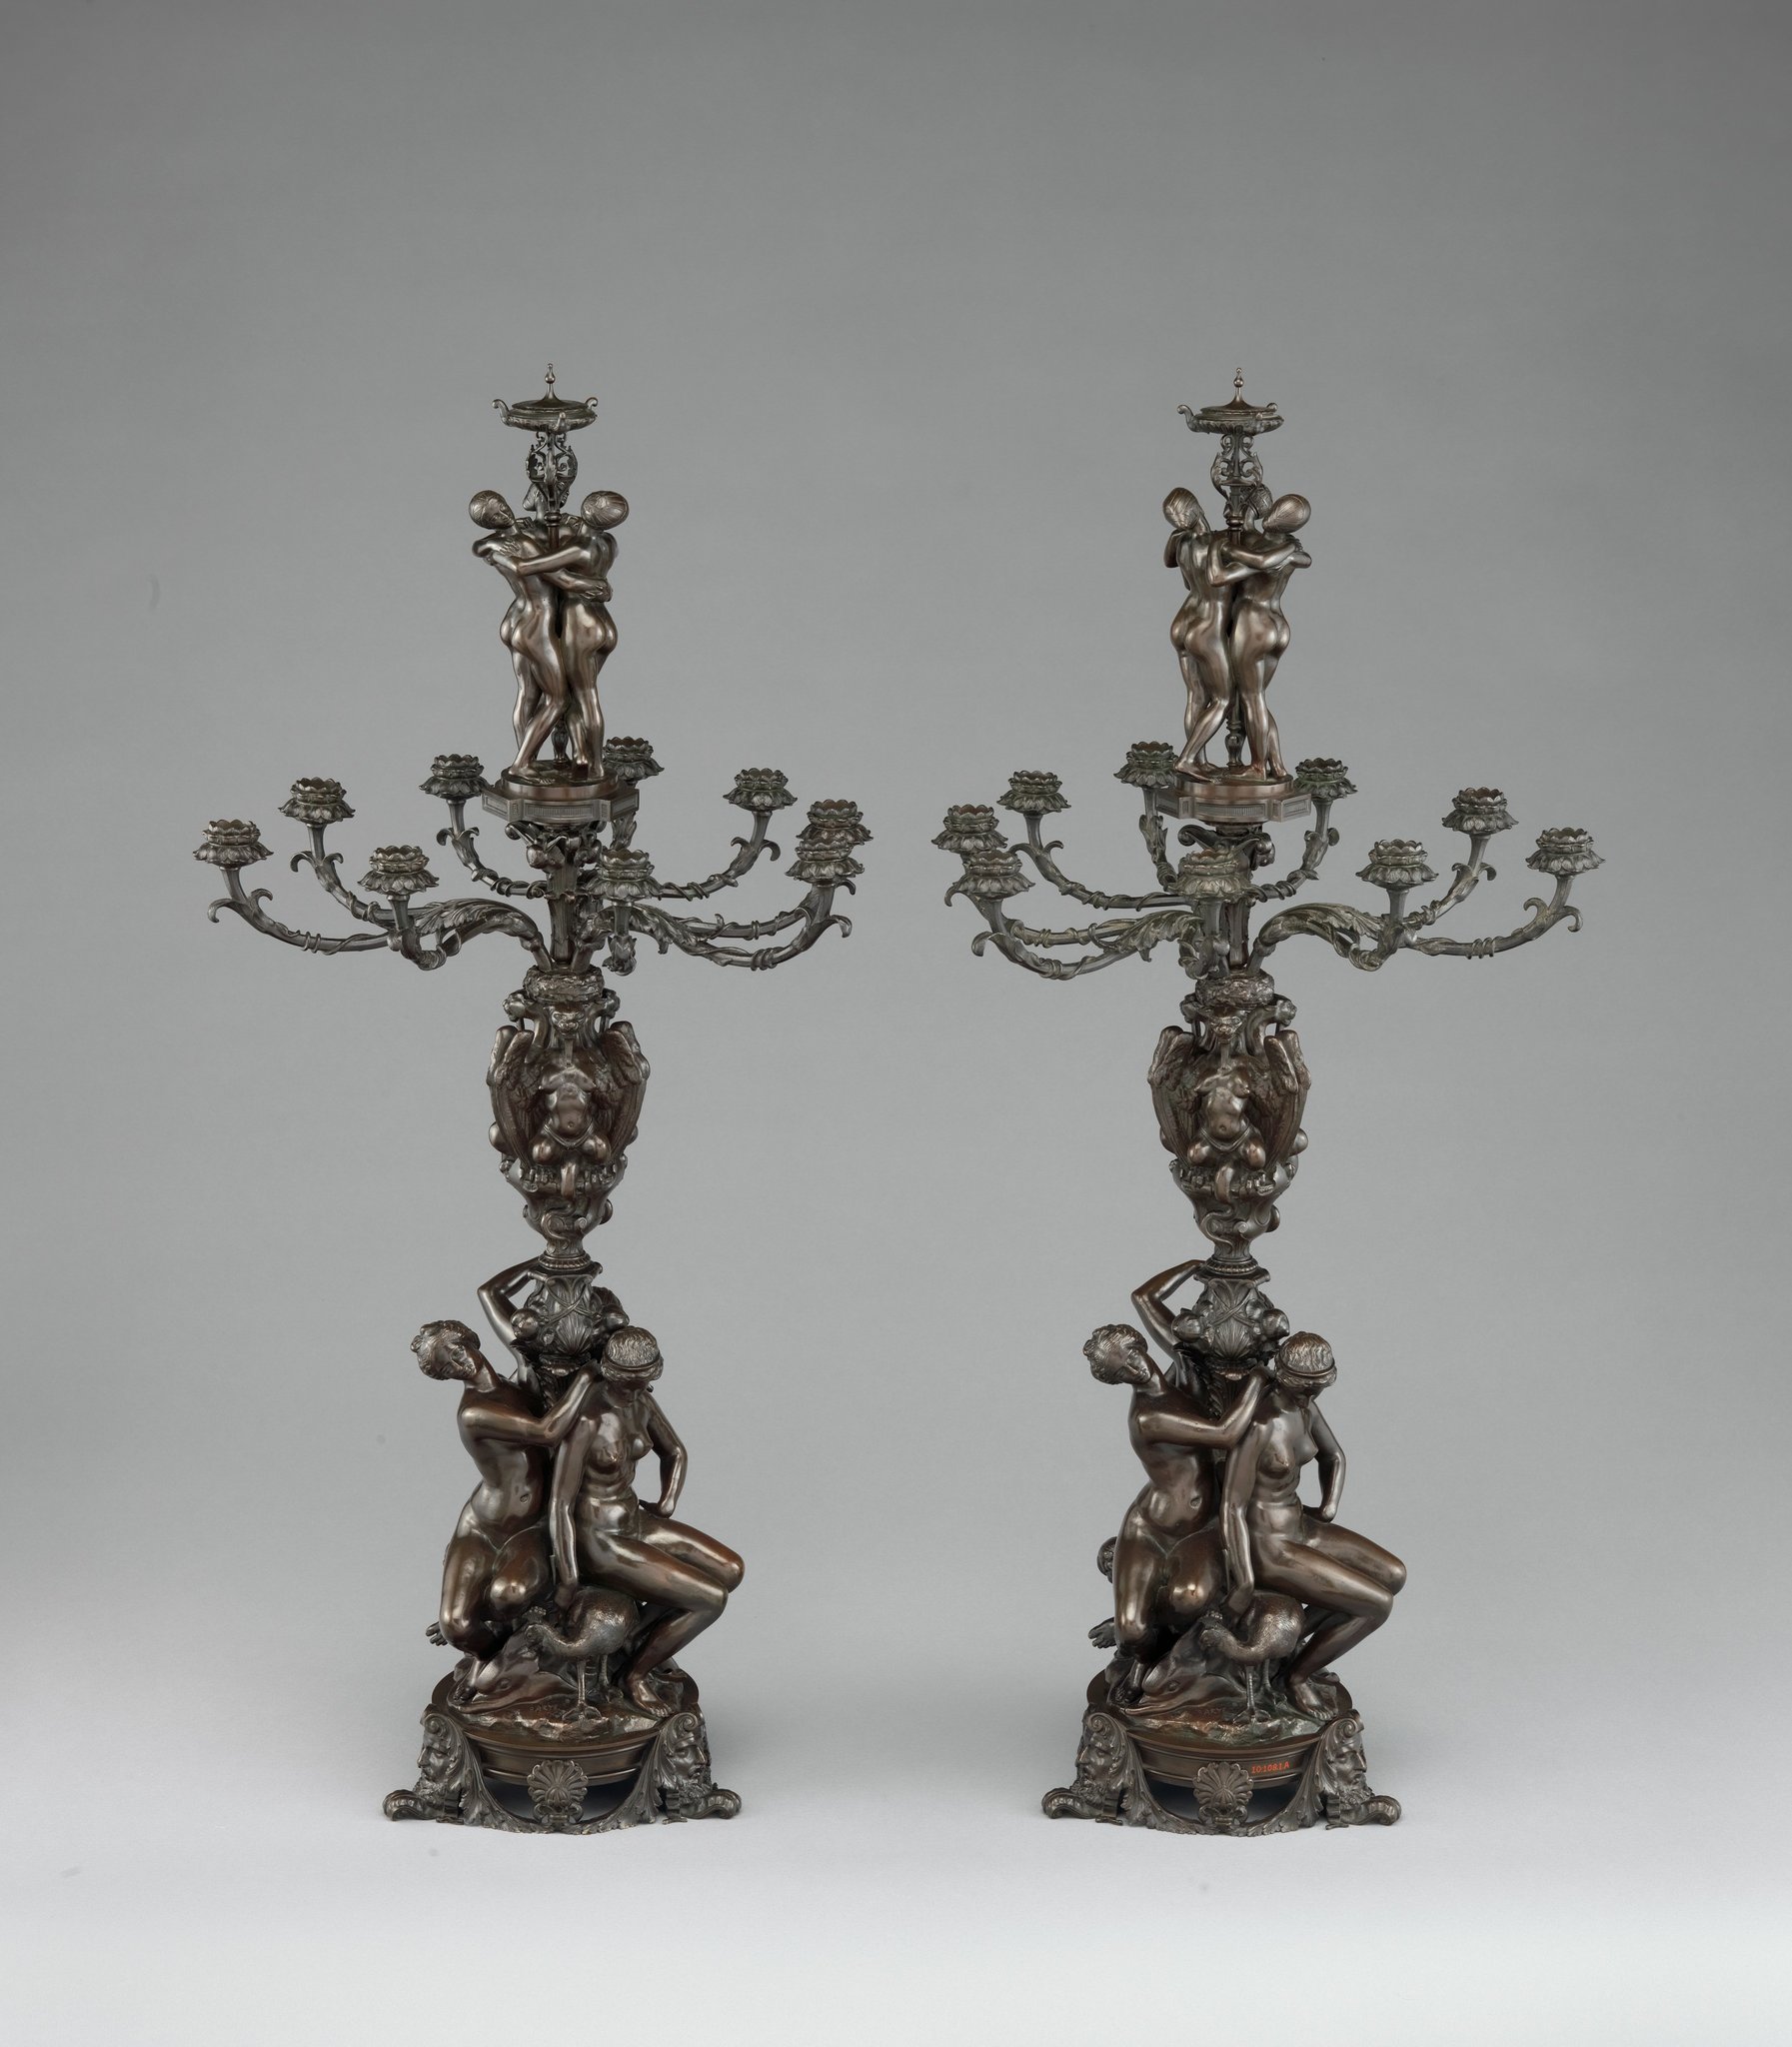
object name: candelabrum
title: Pair of candelabra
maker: antoine-louis barye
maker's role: artist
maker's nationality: french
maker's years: 1795-1875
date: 1840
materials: bronze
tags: juno,minerva,venus,peacocks